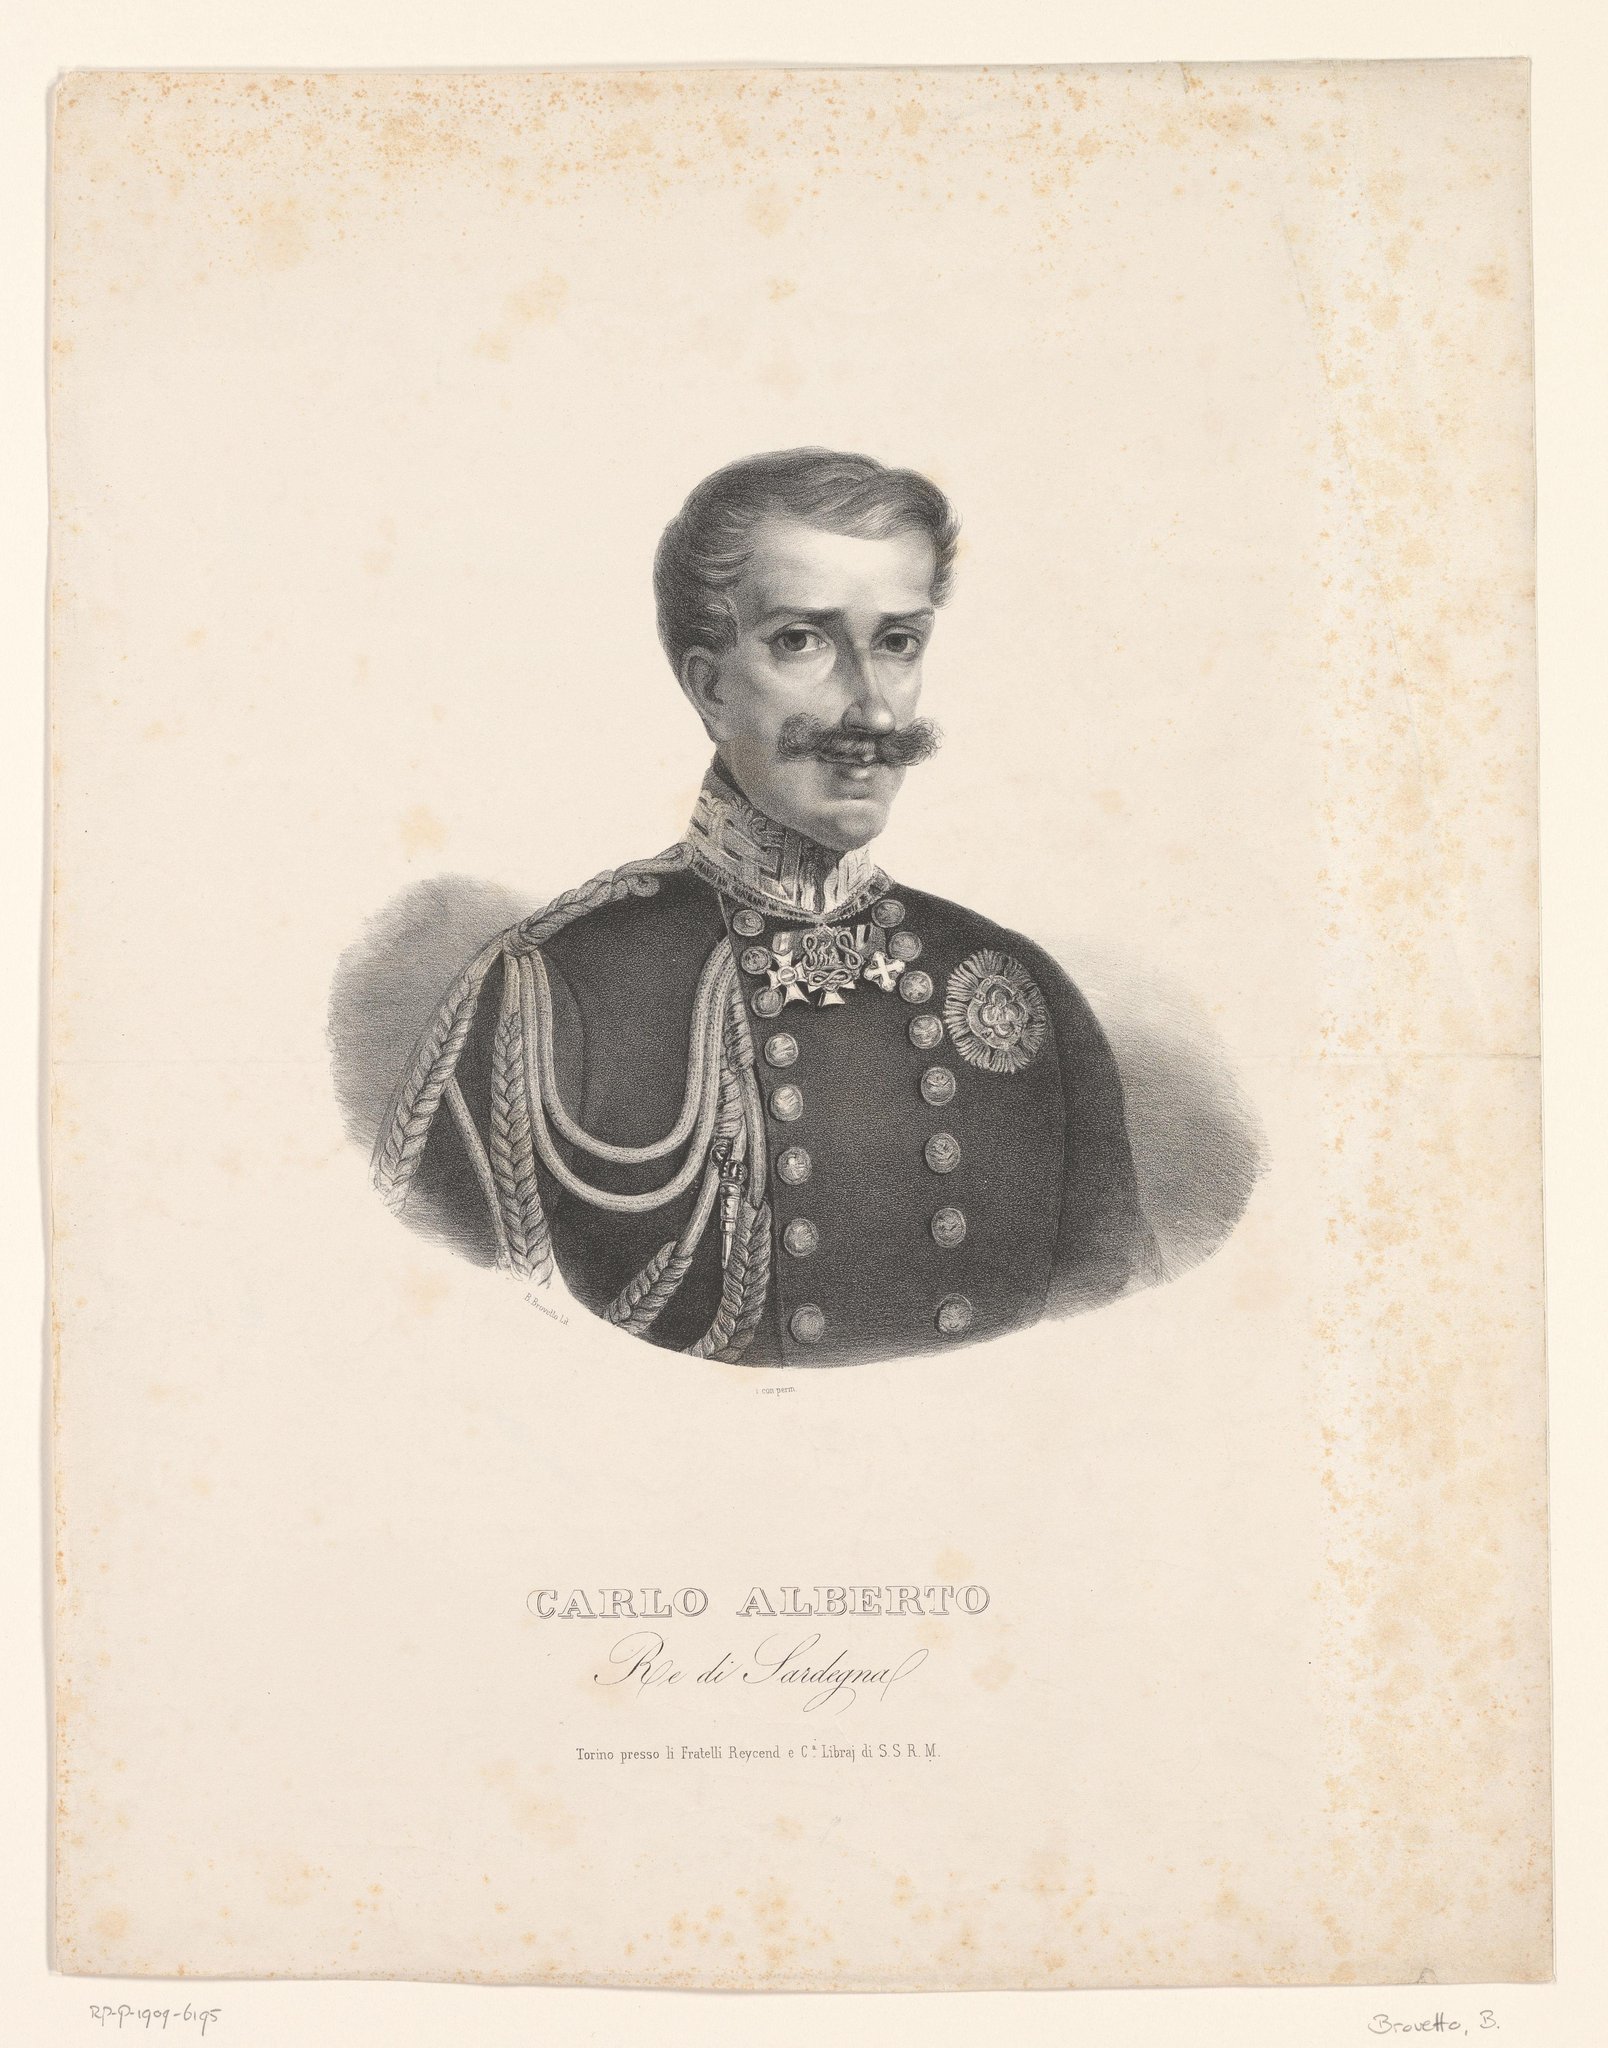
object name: print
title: Carlo Alberto/ Re di Sardegna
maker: b. brovetto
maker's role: print maker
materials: paper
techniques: lithograph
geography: turin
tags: historical persons, ruler, sovereign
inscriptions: collector's mark: Lugt 2228